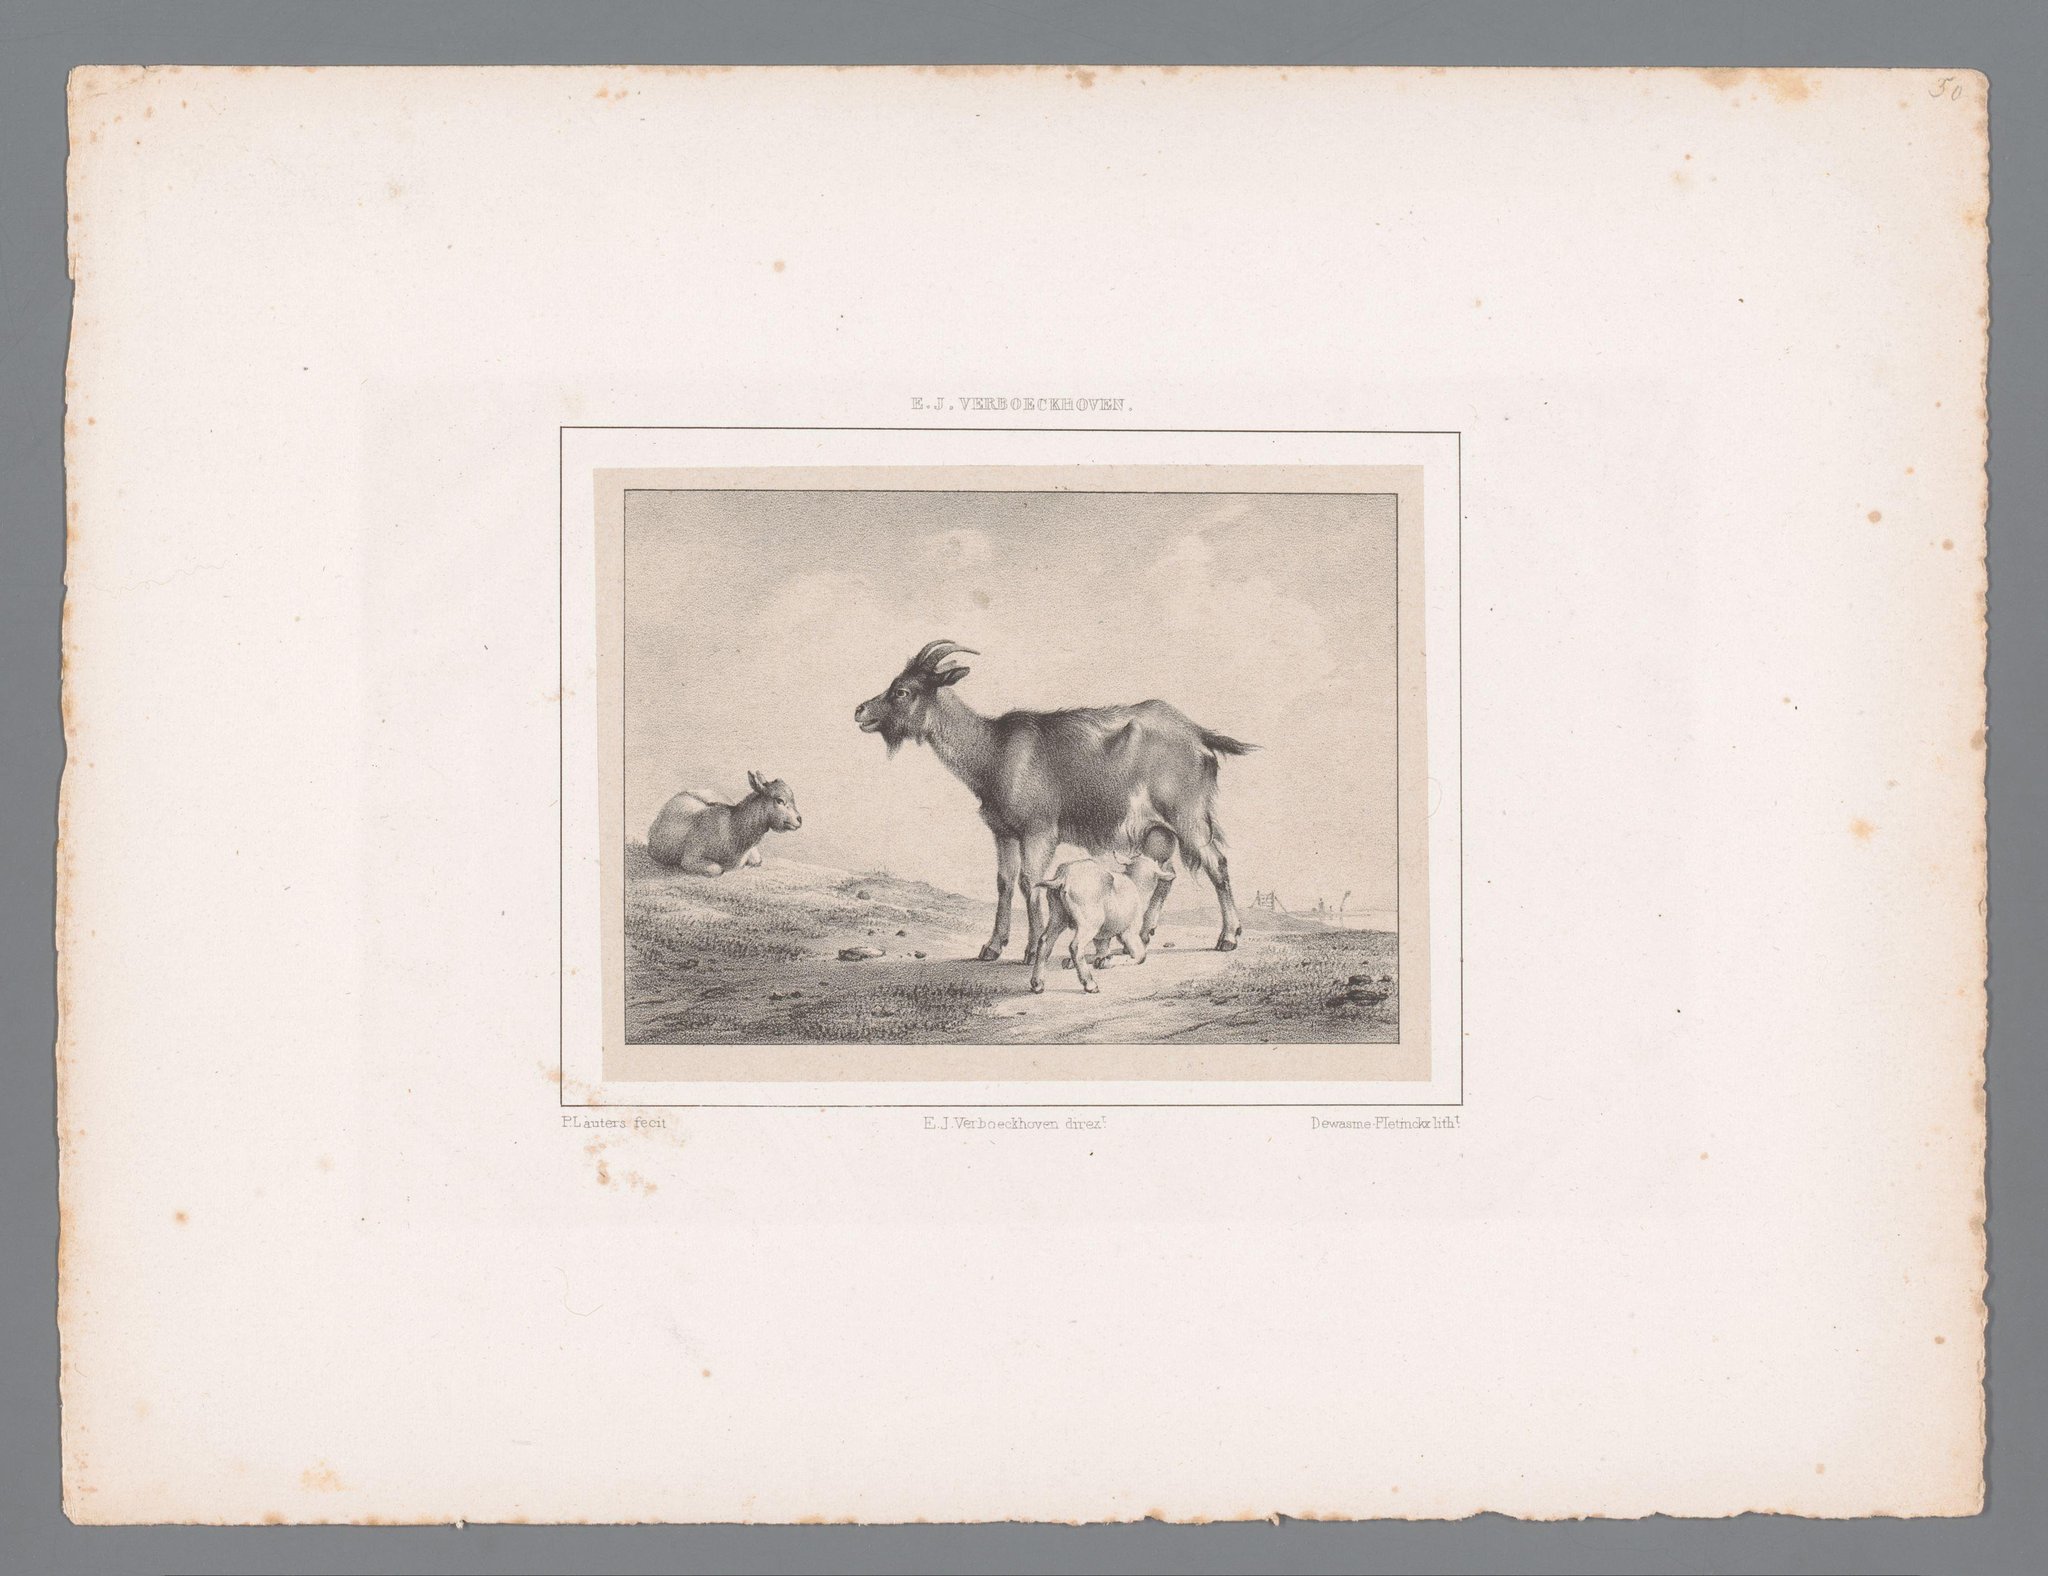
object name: print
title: Geit met jong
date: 1829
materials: paper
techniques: lithograph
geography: brussels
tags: she-goat, nanny-goat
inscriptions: collector's mark: Lugt 2233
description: Prent verschenen in: Verboeckhoven, Eugène. Album lithographié par Paul Lauters d'après les dessins des principaux peintres du Royaume des Pays-Bas. Brussel: Antoine Dewasme-Pletinckx, 1829.